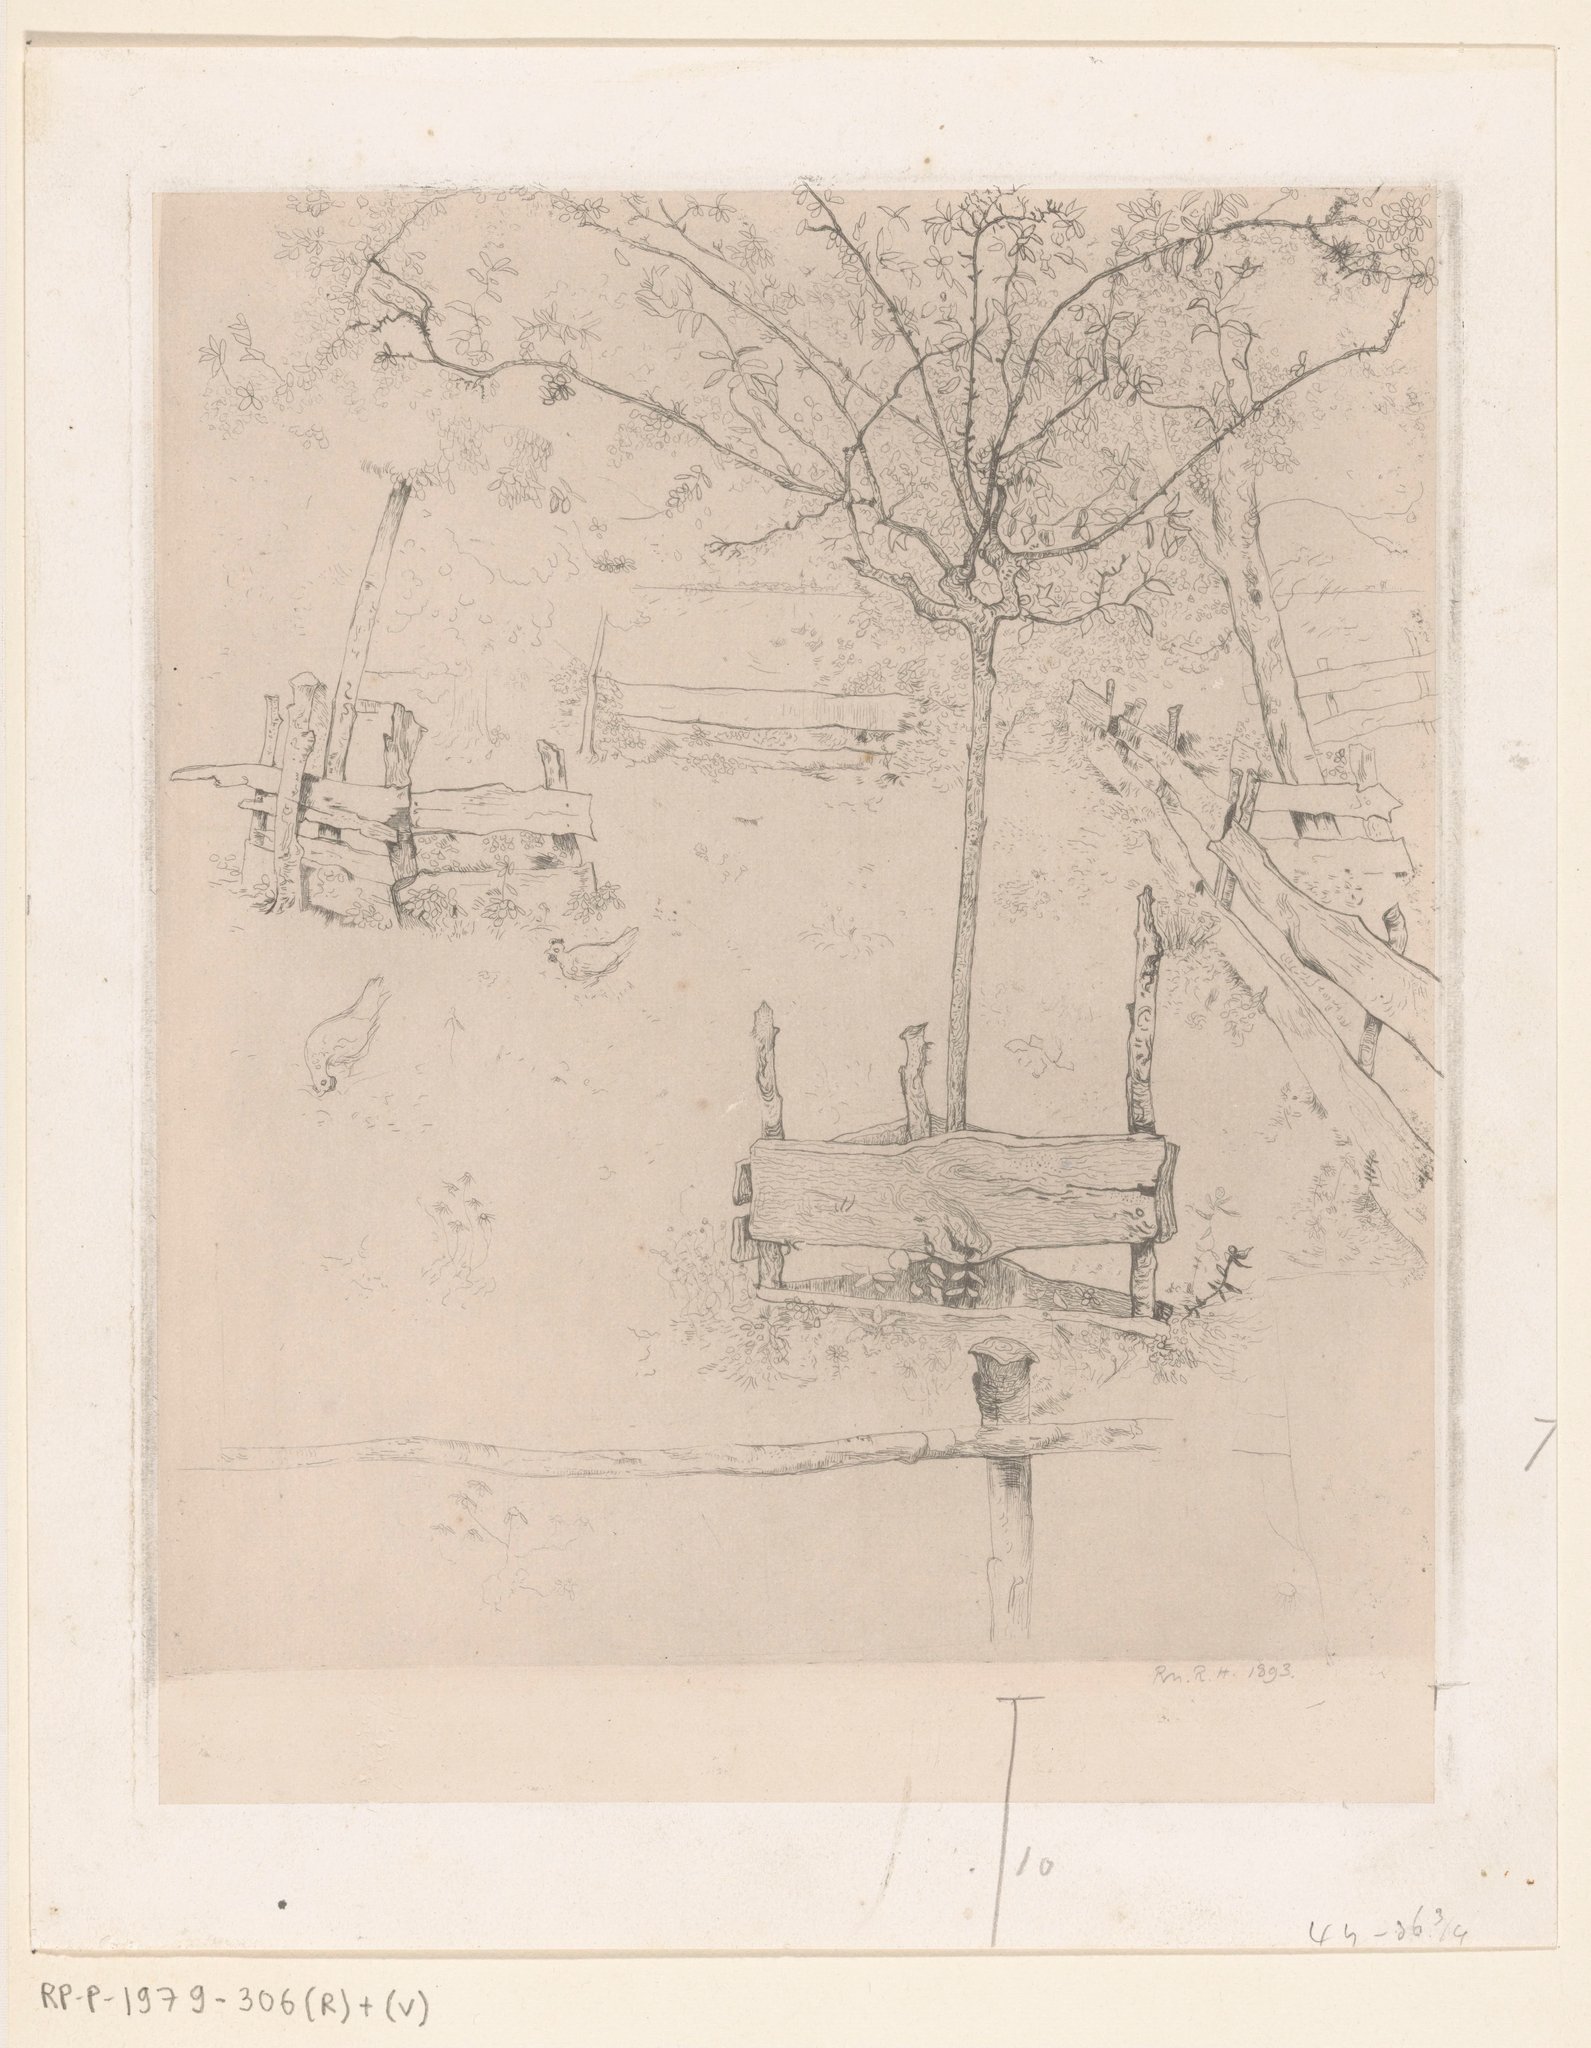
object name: print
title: Boomgaard in Eemnes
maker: richard nicolaüs roland holst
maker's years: 1868-1938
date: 1893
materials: paper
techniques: etching, intaglio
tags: orchard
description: Een met hekken begrensd veld met daarin een fruitboom en twee scharrelende kippen.